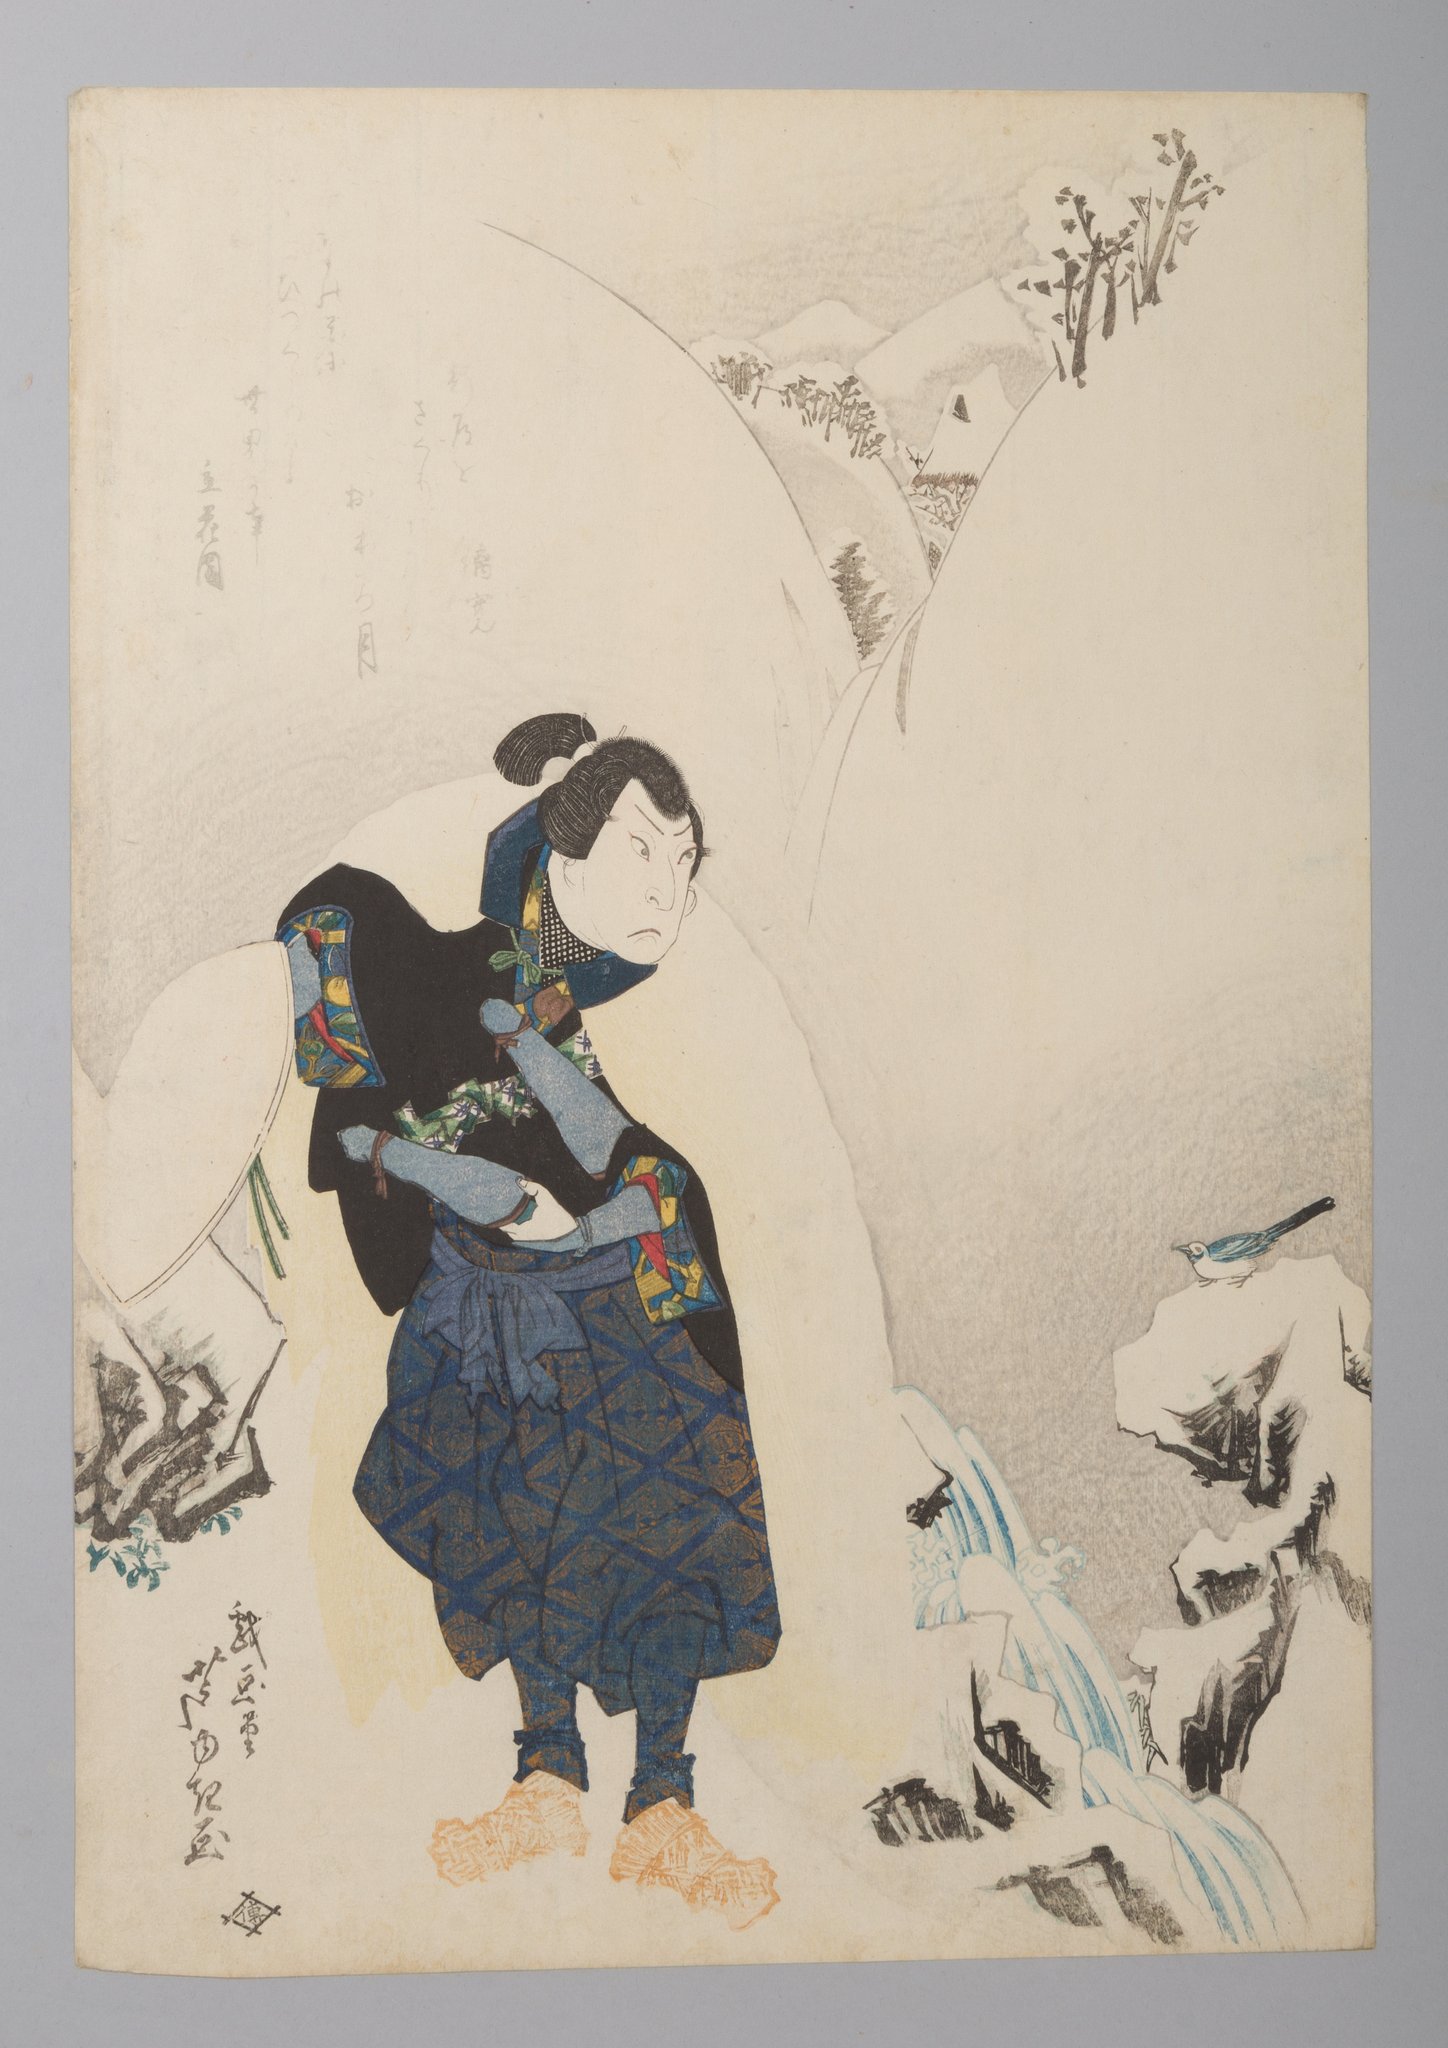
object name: woodblock print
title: Arashi Rikan II as Miyamoto Musashi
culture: japanese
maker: gigadō ashiyuki 戯画堂芦幸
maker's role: artist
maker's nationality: japanese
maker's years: 1813-1834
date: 1832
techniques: nishiki e, woodblock print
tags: birds,men,actors